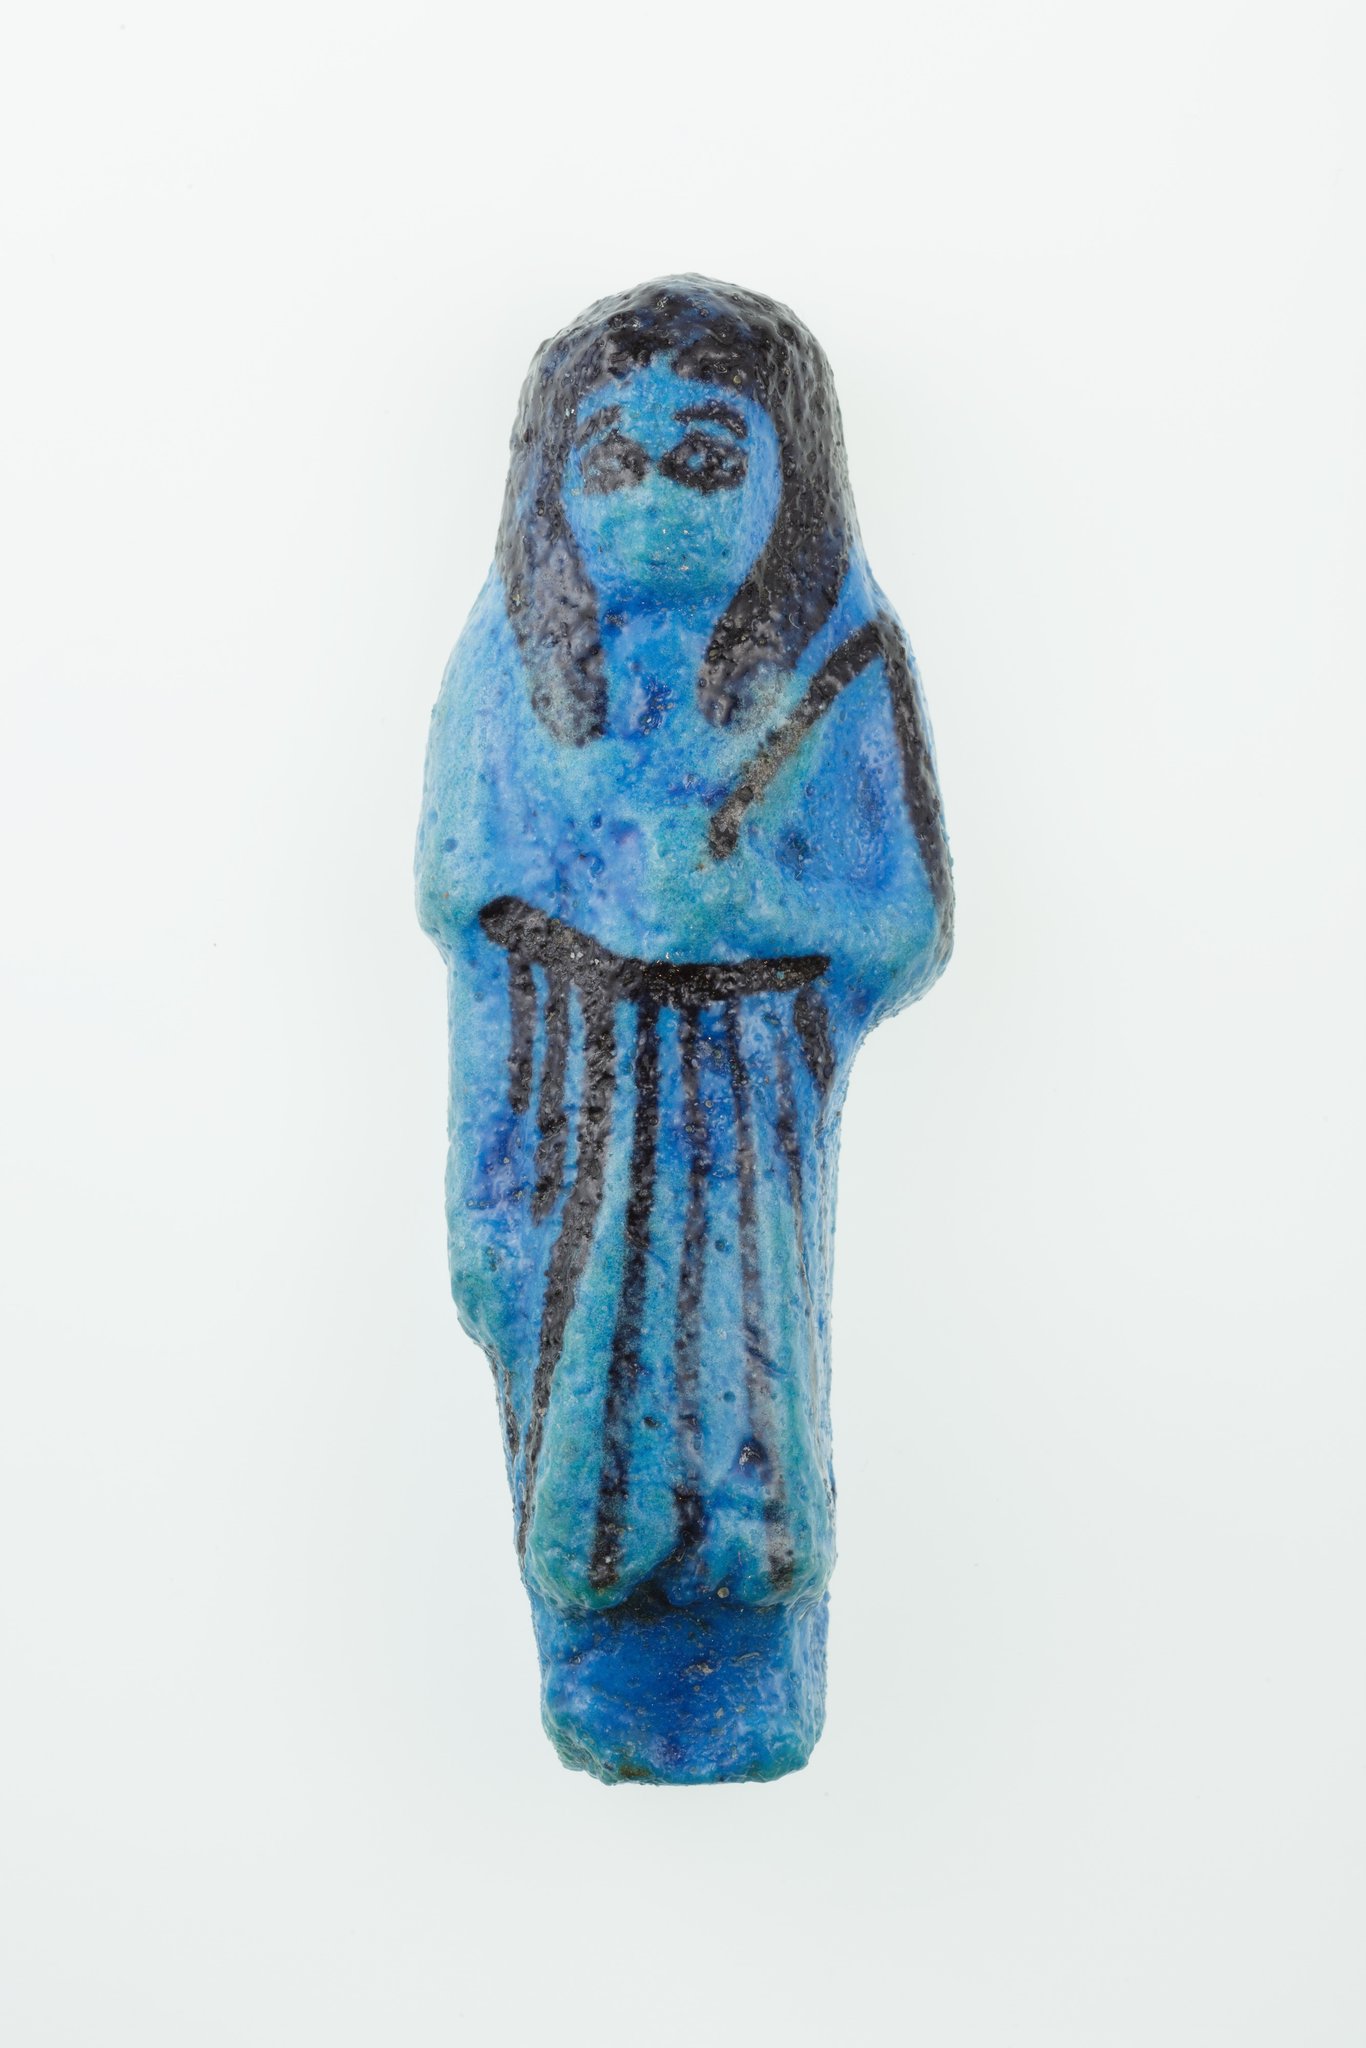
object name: shabti, nauny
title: Overseer Shabti of Nauny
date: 1050 BCE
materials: faience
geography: egypt